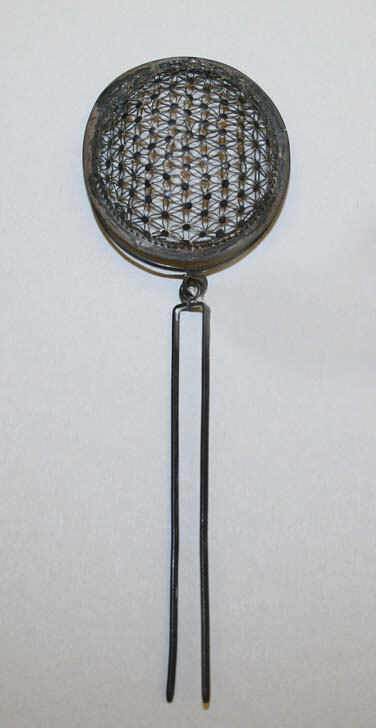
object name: hair accessory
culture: american or european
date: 1800-1850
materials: metal